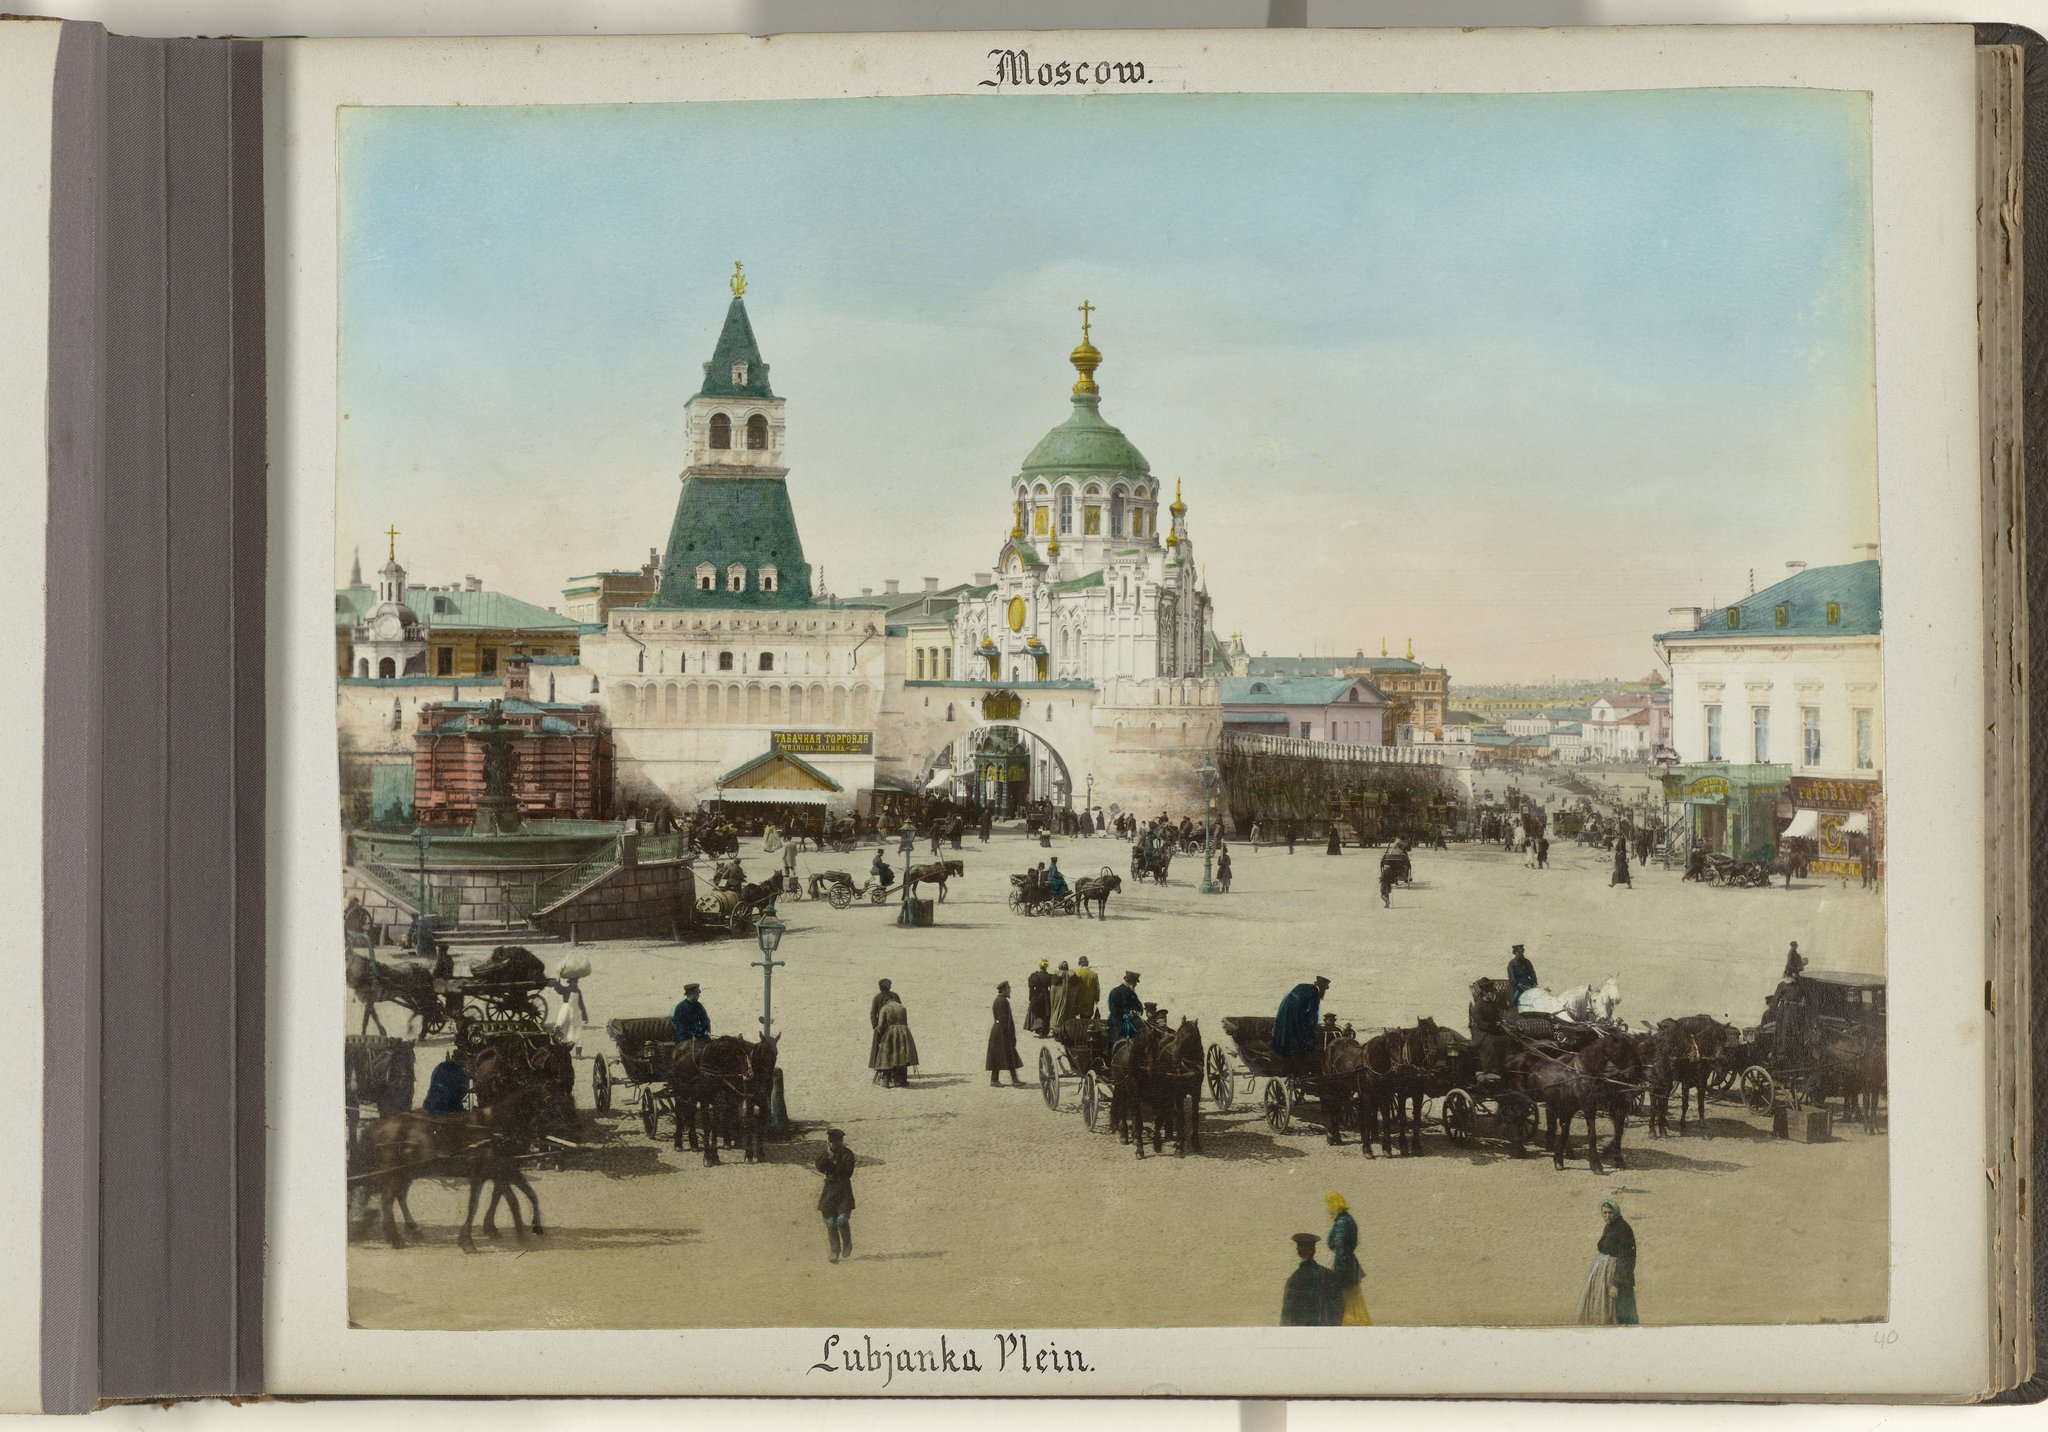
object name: photograph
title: Lubyanka plein, gelegen voor een ommuurd stadsdeel in Moskou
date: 1898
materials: paper, photographic support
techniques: albumen print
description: Een ingekleurde foto vanaf het Lubyanka plein in Moskou. Op de voorgrond staan een aantal rijtuigen bij elkaar.